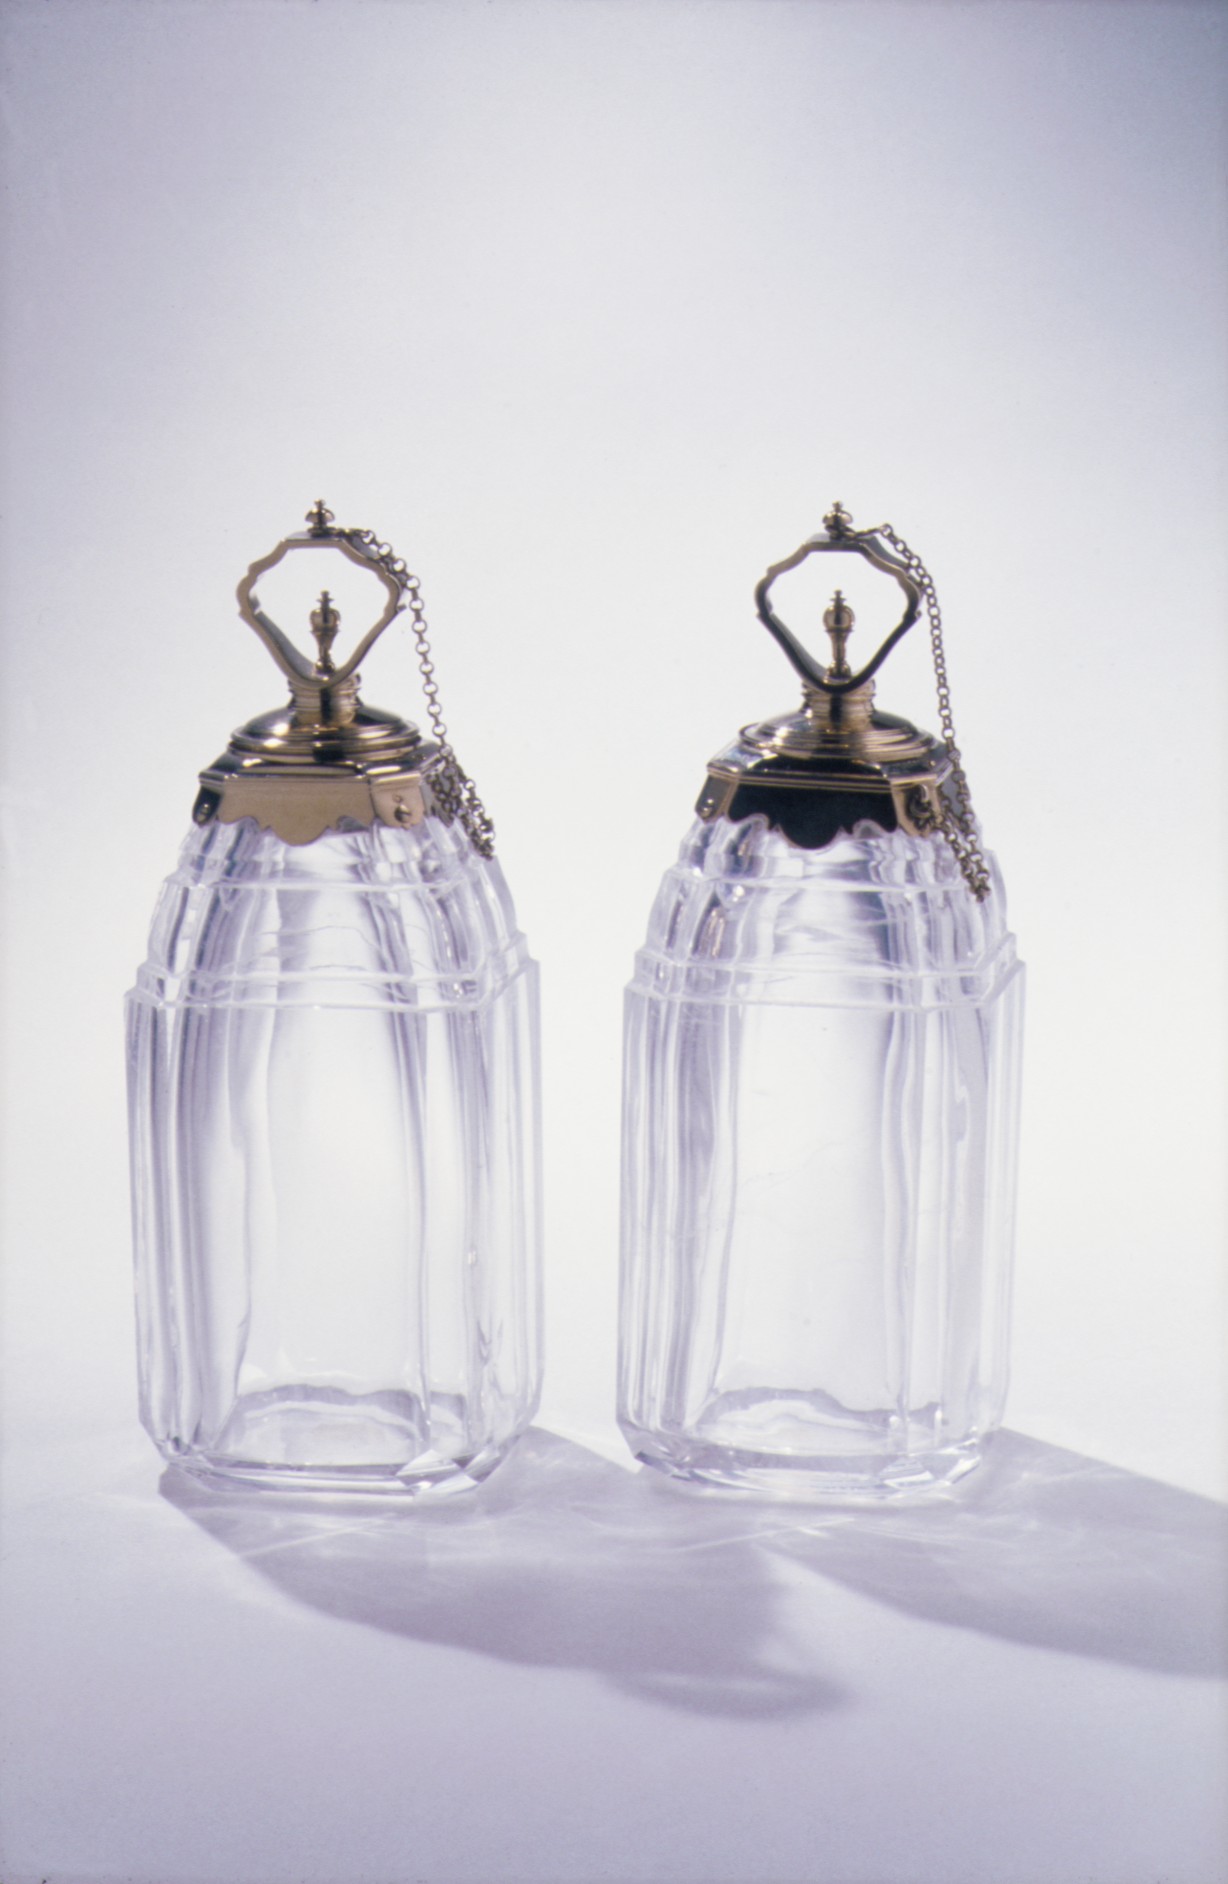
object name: perfume bottle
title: Perfume bottle (one of six) (part of a set)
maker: louis mailly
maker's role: maker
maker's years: 1639-1739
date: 1728-1730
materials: gold, quartz